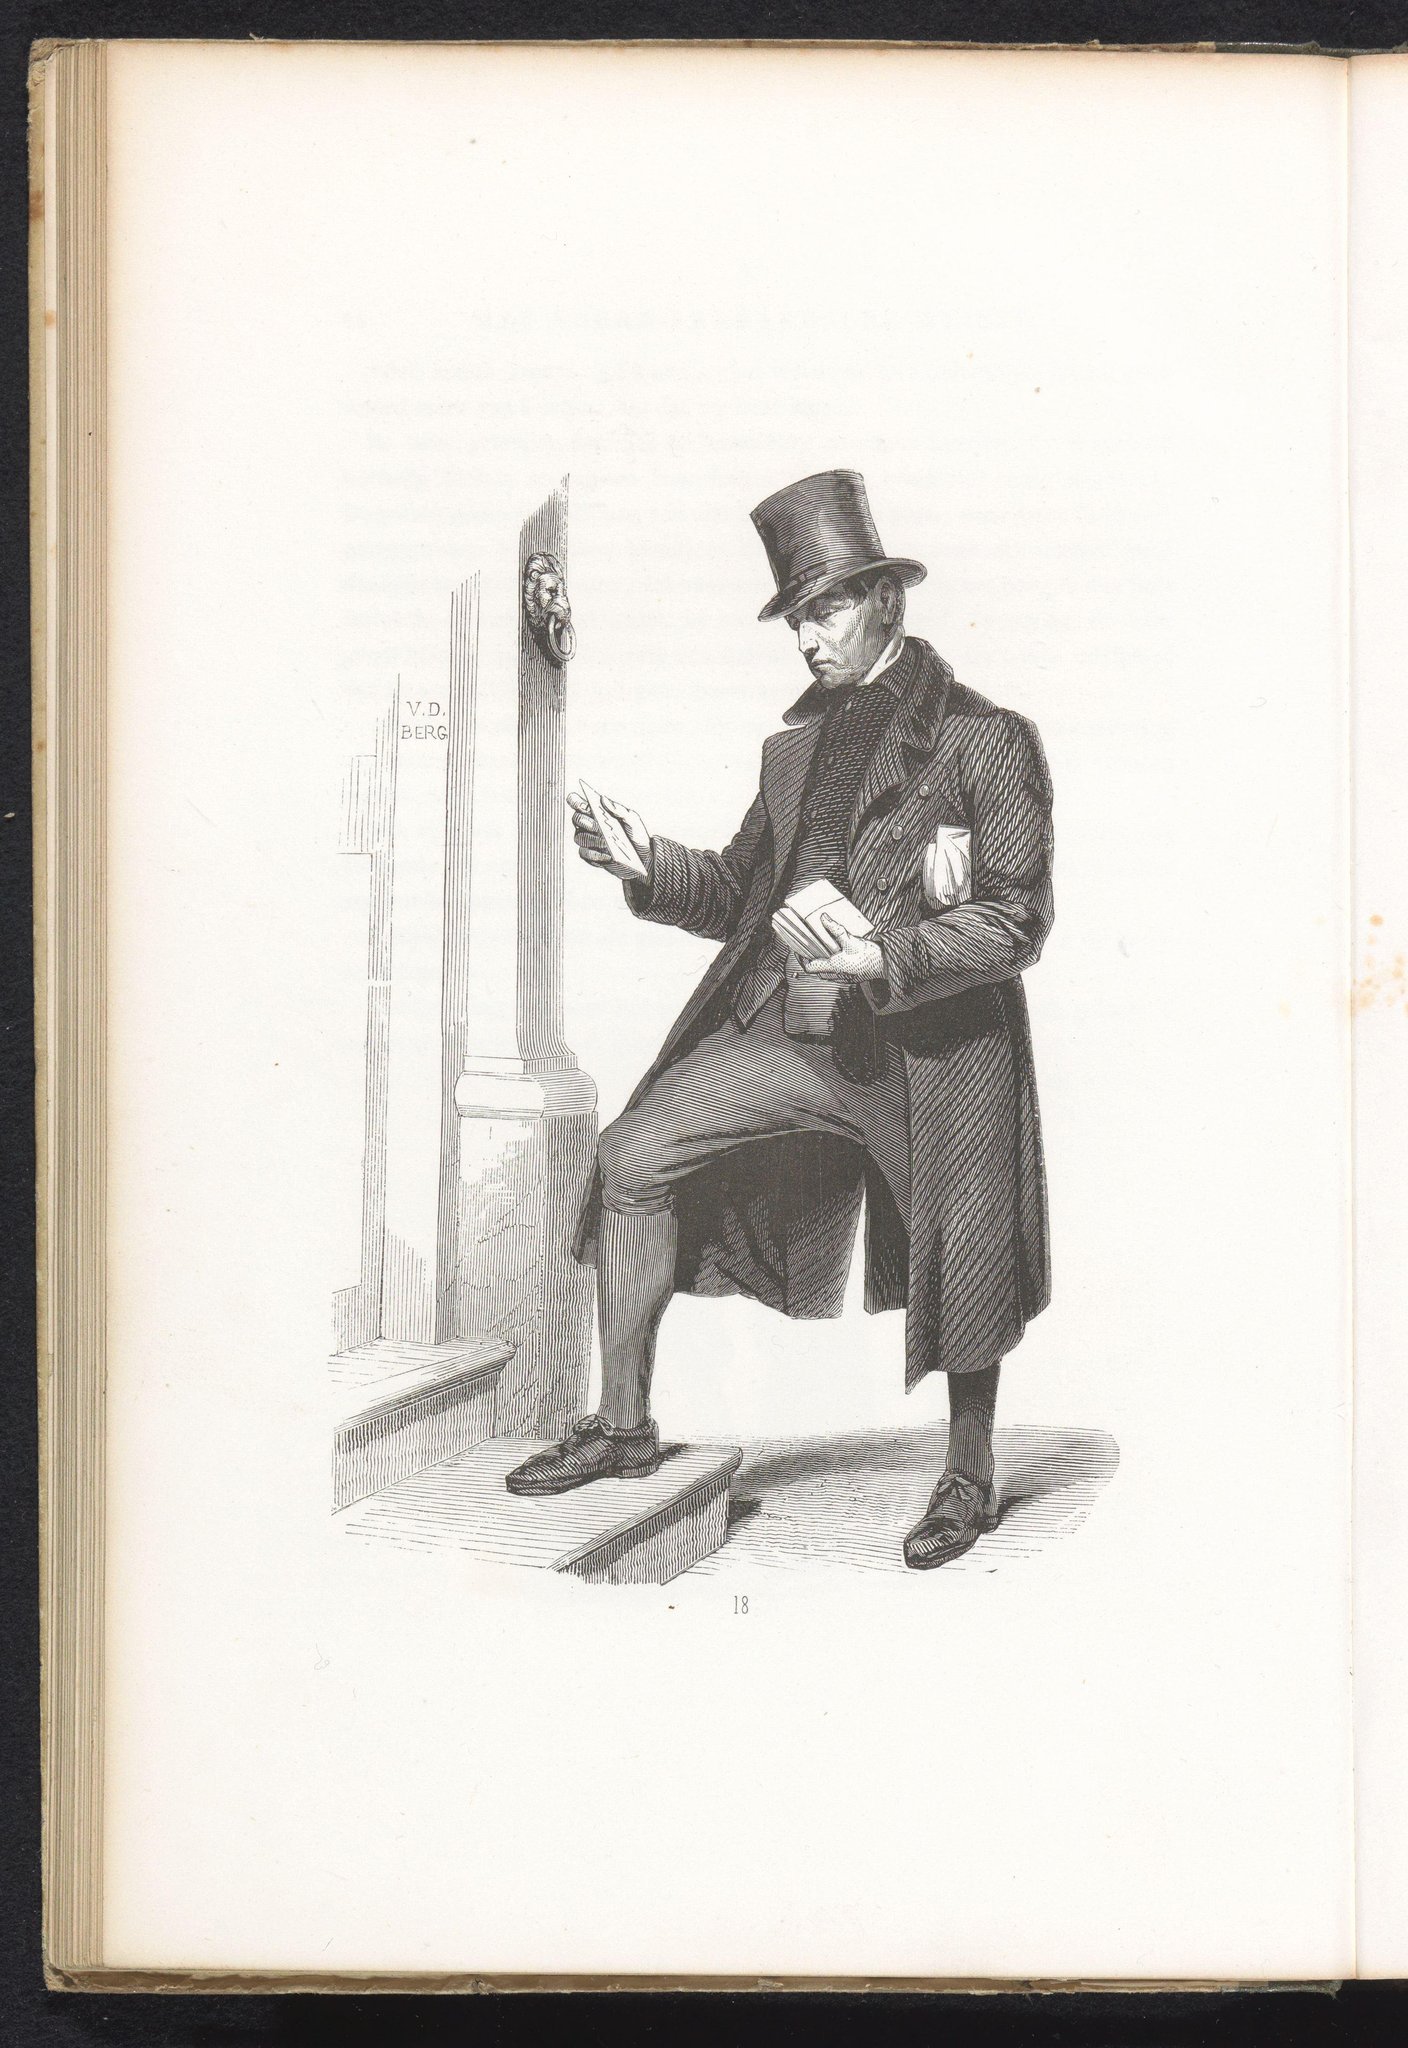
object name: print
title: De brievenbesteller, 1840-1841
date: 1841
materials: paper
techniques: letterpress printing, engraving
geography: netherlands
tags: professional clothes, postman, netherlands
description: De brievenbesteller. Een man bezorgt brieven bij een huis. Genummerd: 18. Illustratie in het boek 'De Nederlanden: karakterschetsen, kleederdrachten, houding en voorkomen van verschillende standen', een boek met karakterschetsen, beroepen en klederdrachten van Nederlandse volkstypen uit 1841.